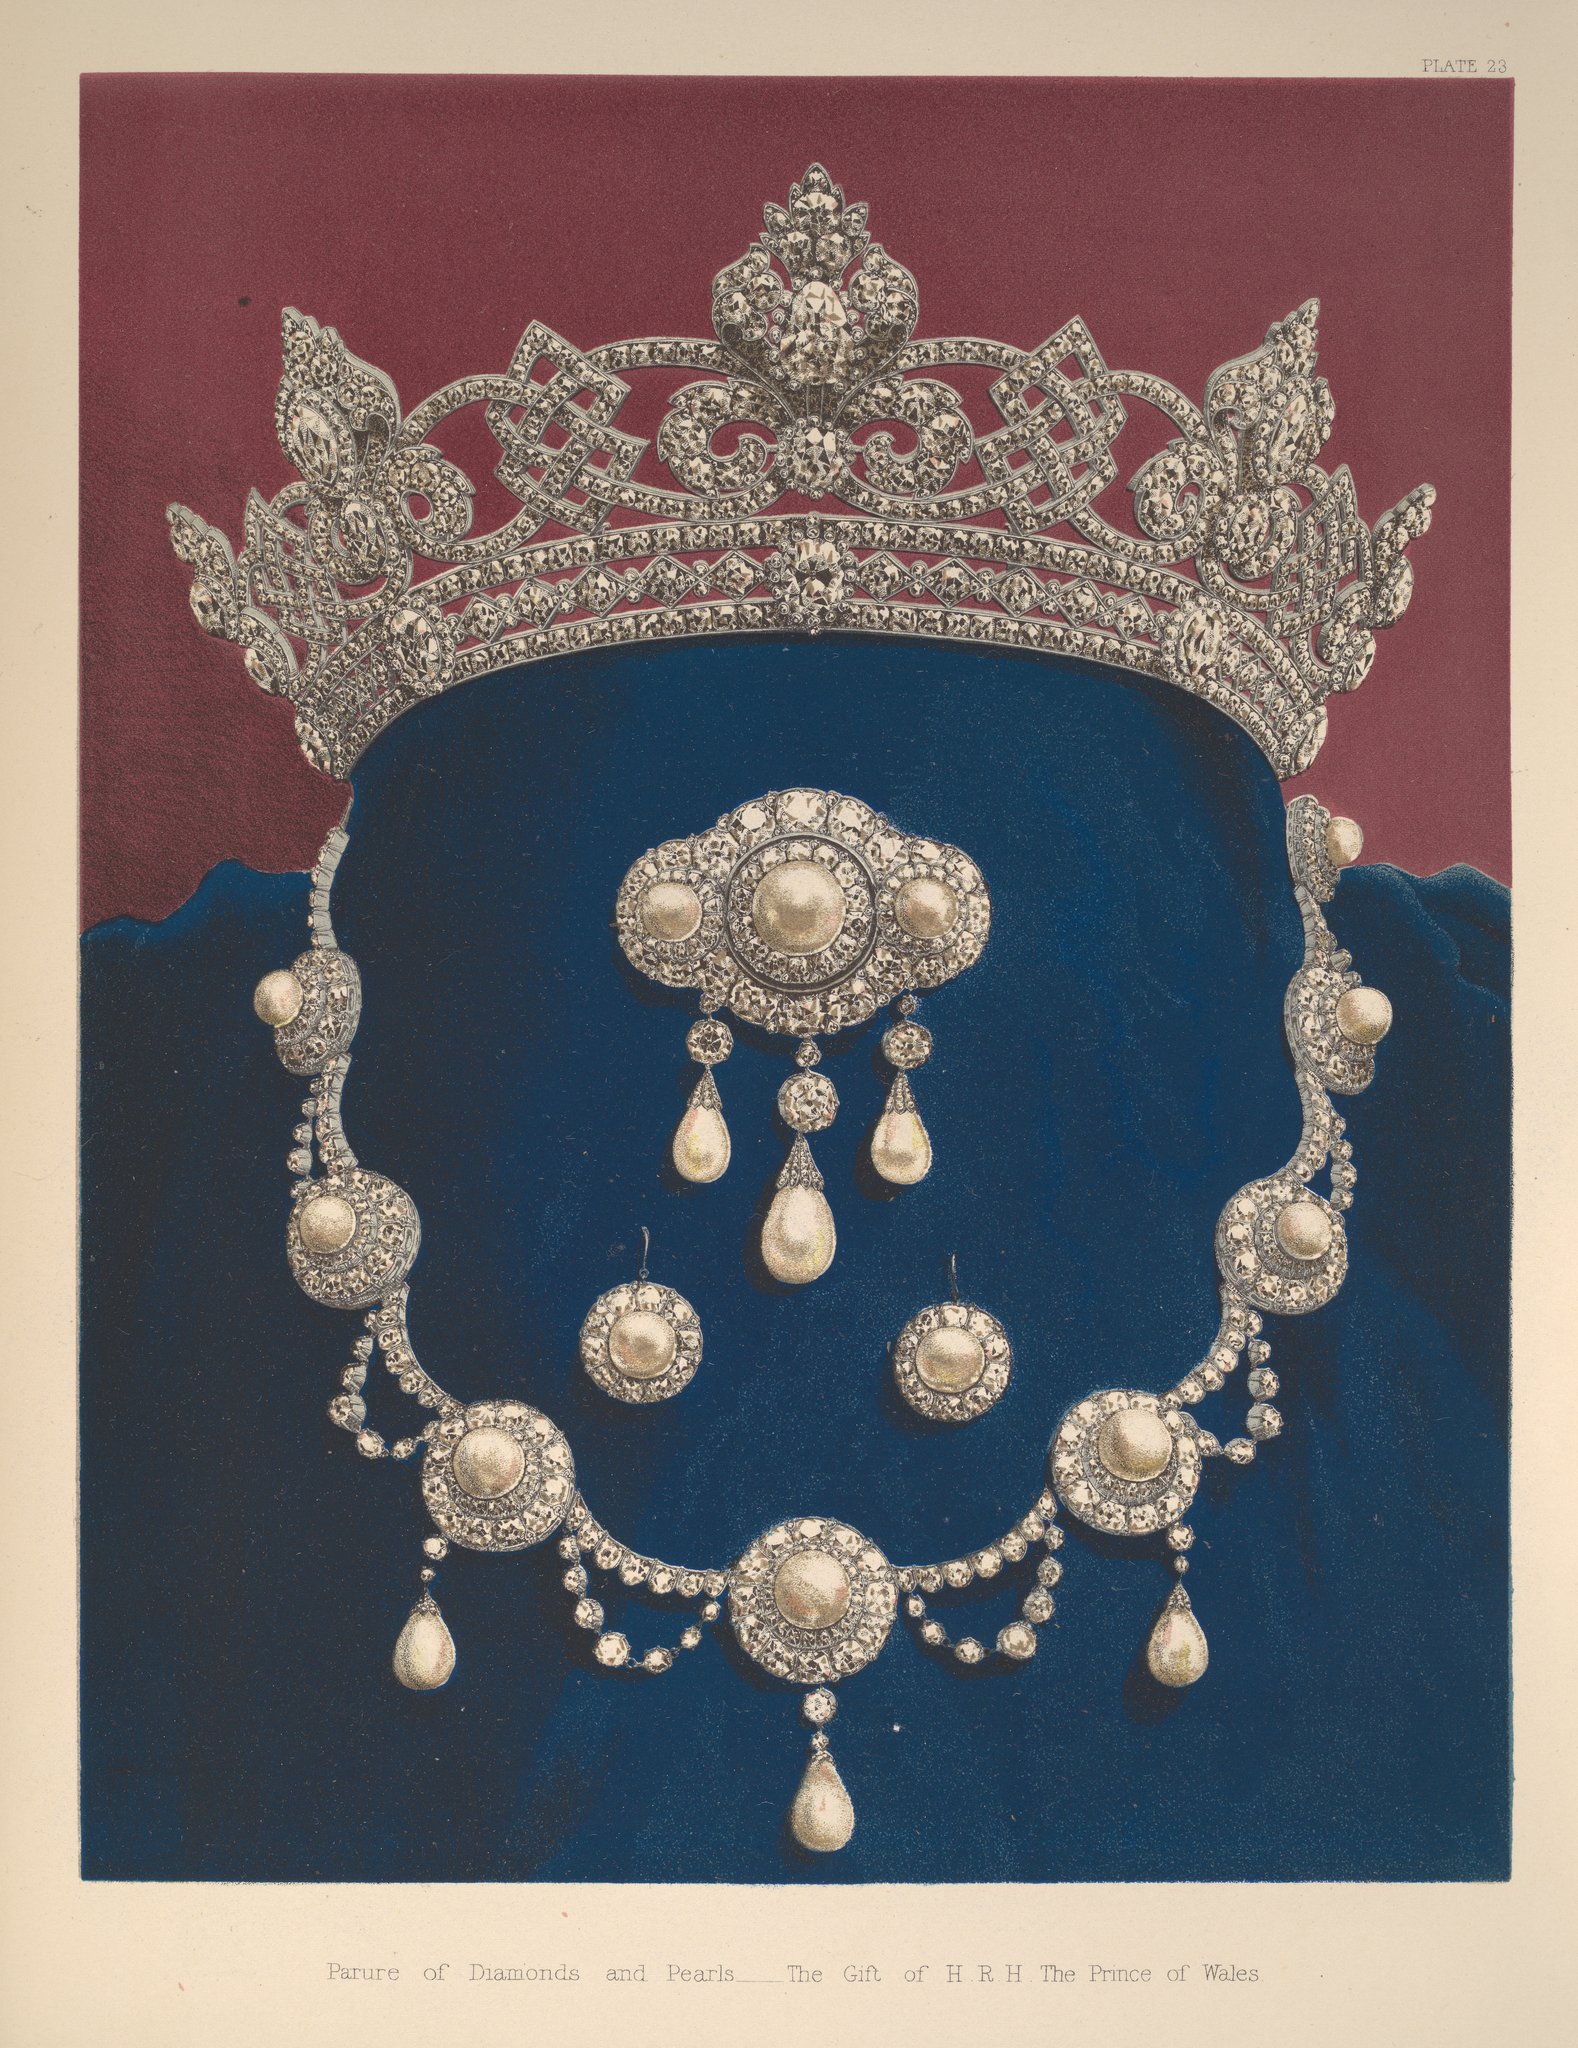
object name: book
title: A Memorial of the Marriage of H.R.H. Albert Edward Prince of Wales and H.R.H. Alexandra, Princess of Denmark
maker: sir william howard russell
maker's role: author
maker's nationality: irish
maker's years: 1820-1907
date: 1863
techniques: hand coloring, lithograph, engraving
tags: jewelry,crowns